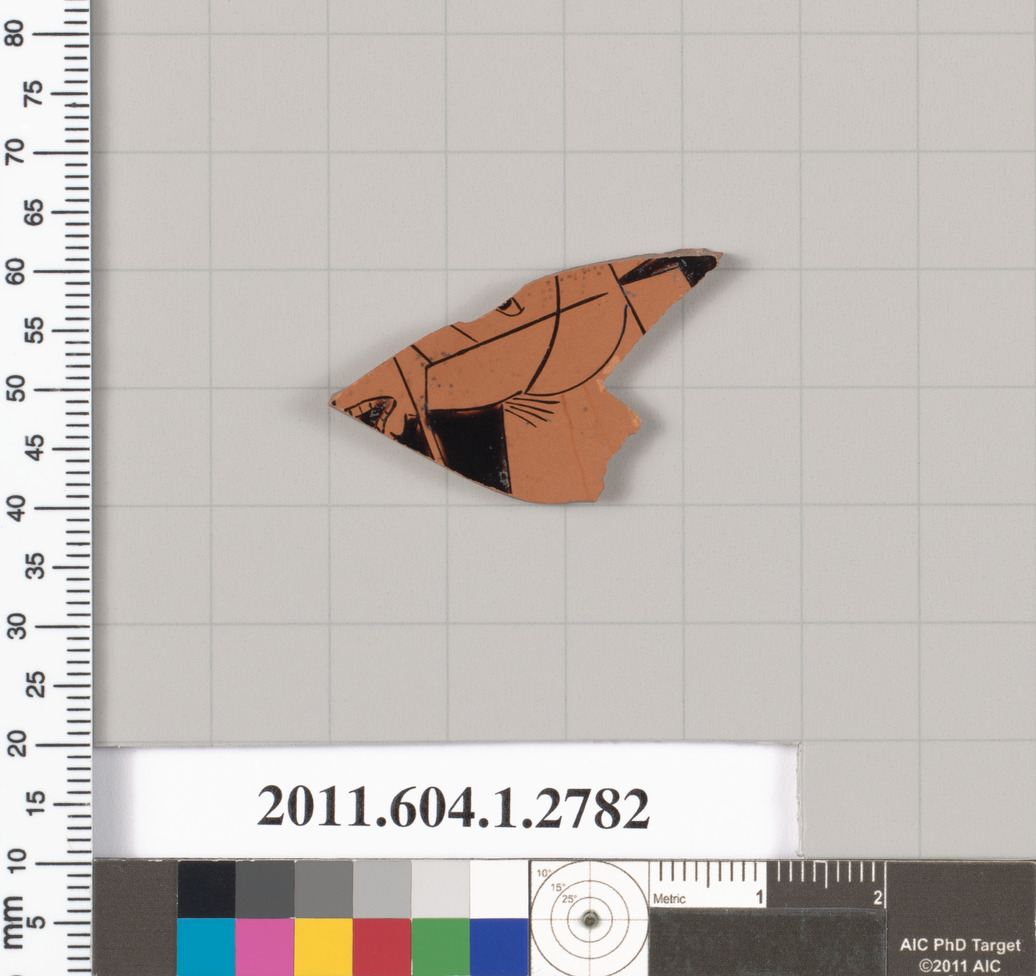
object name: kylix fragment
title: Terracotta fragment of a kylix (drinking cup)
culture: greek, attic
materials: terracotta